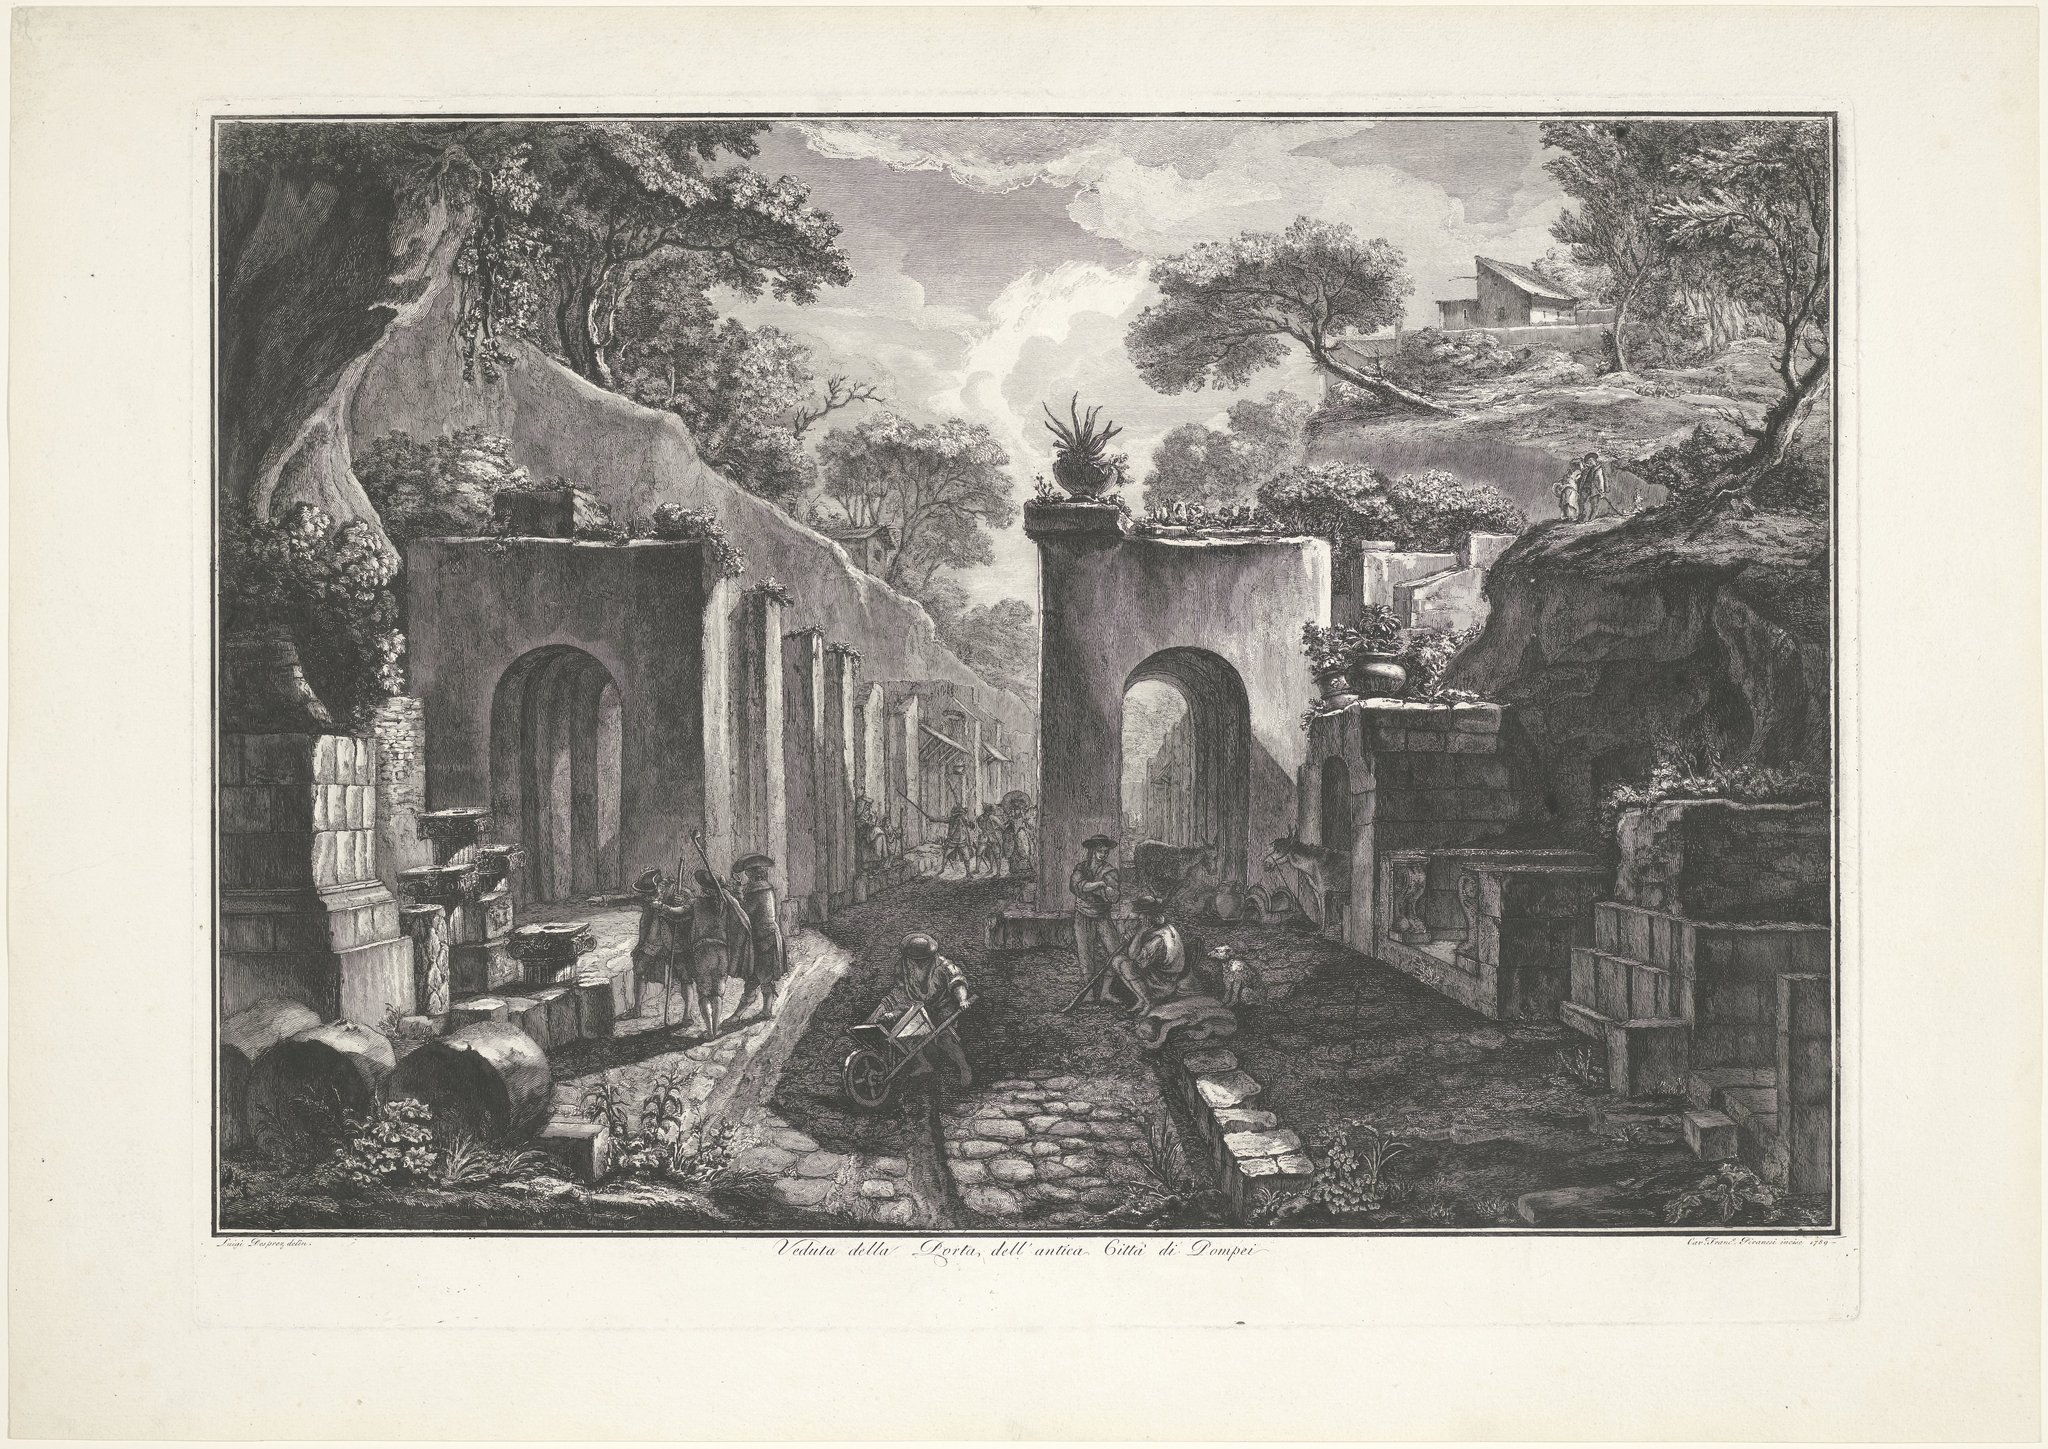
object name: print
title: Veduta della Porta, dell' antica Città di Pompei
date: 1789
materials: paper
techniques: etching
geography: pompeii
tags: landscape with ruins, pompeii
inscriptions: collector's mark: Lugt 2760, collector's mark: Lugt 2228